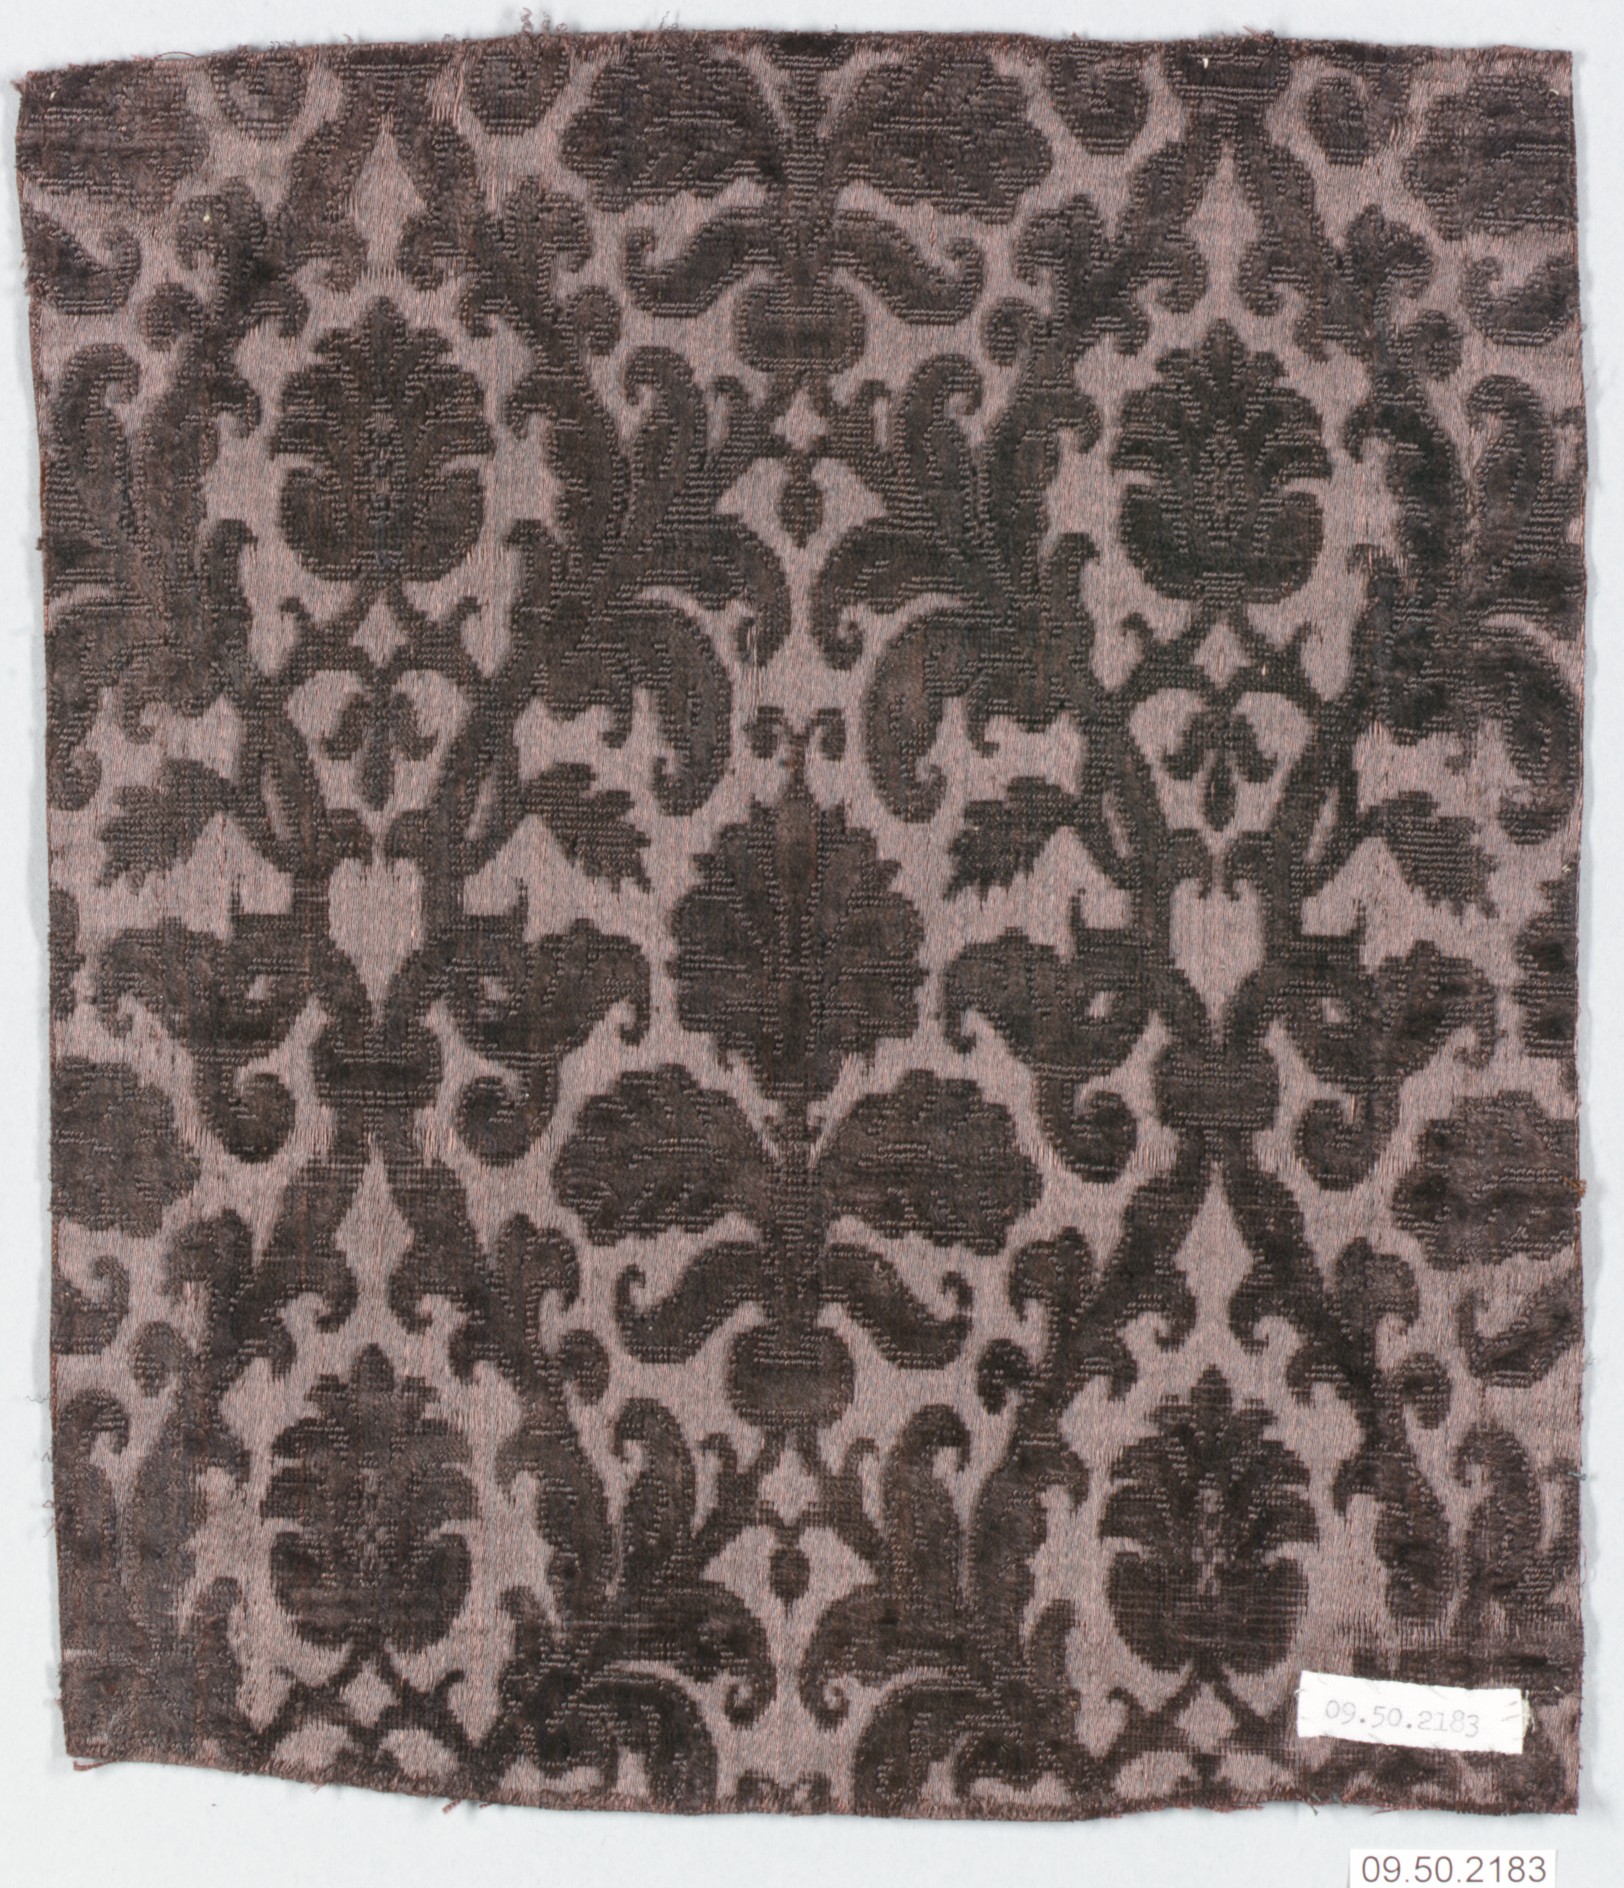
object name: piece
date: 1601-1700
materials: silk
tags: leaves